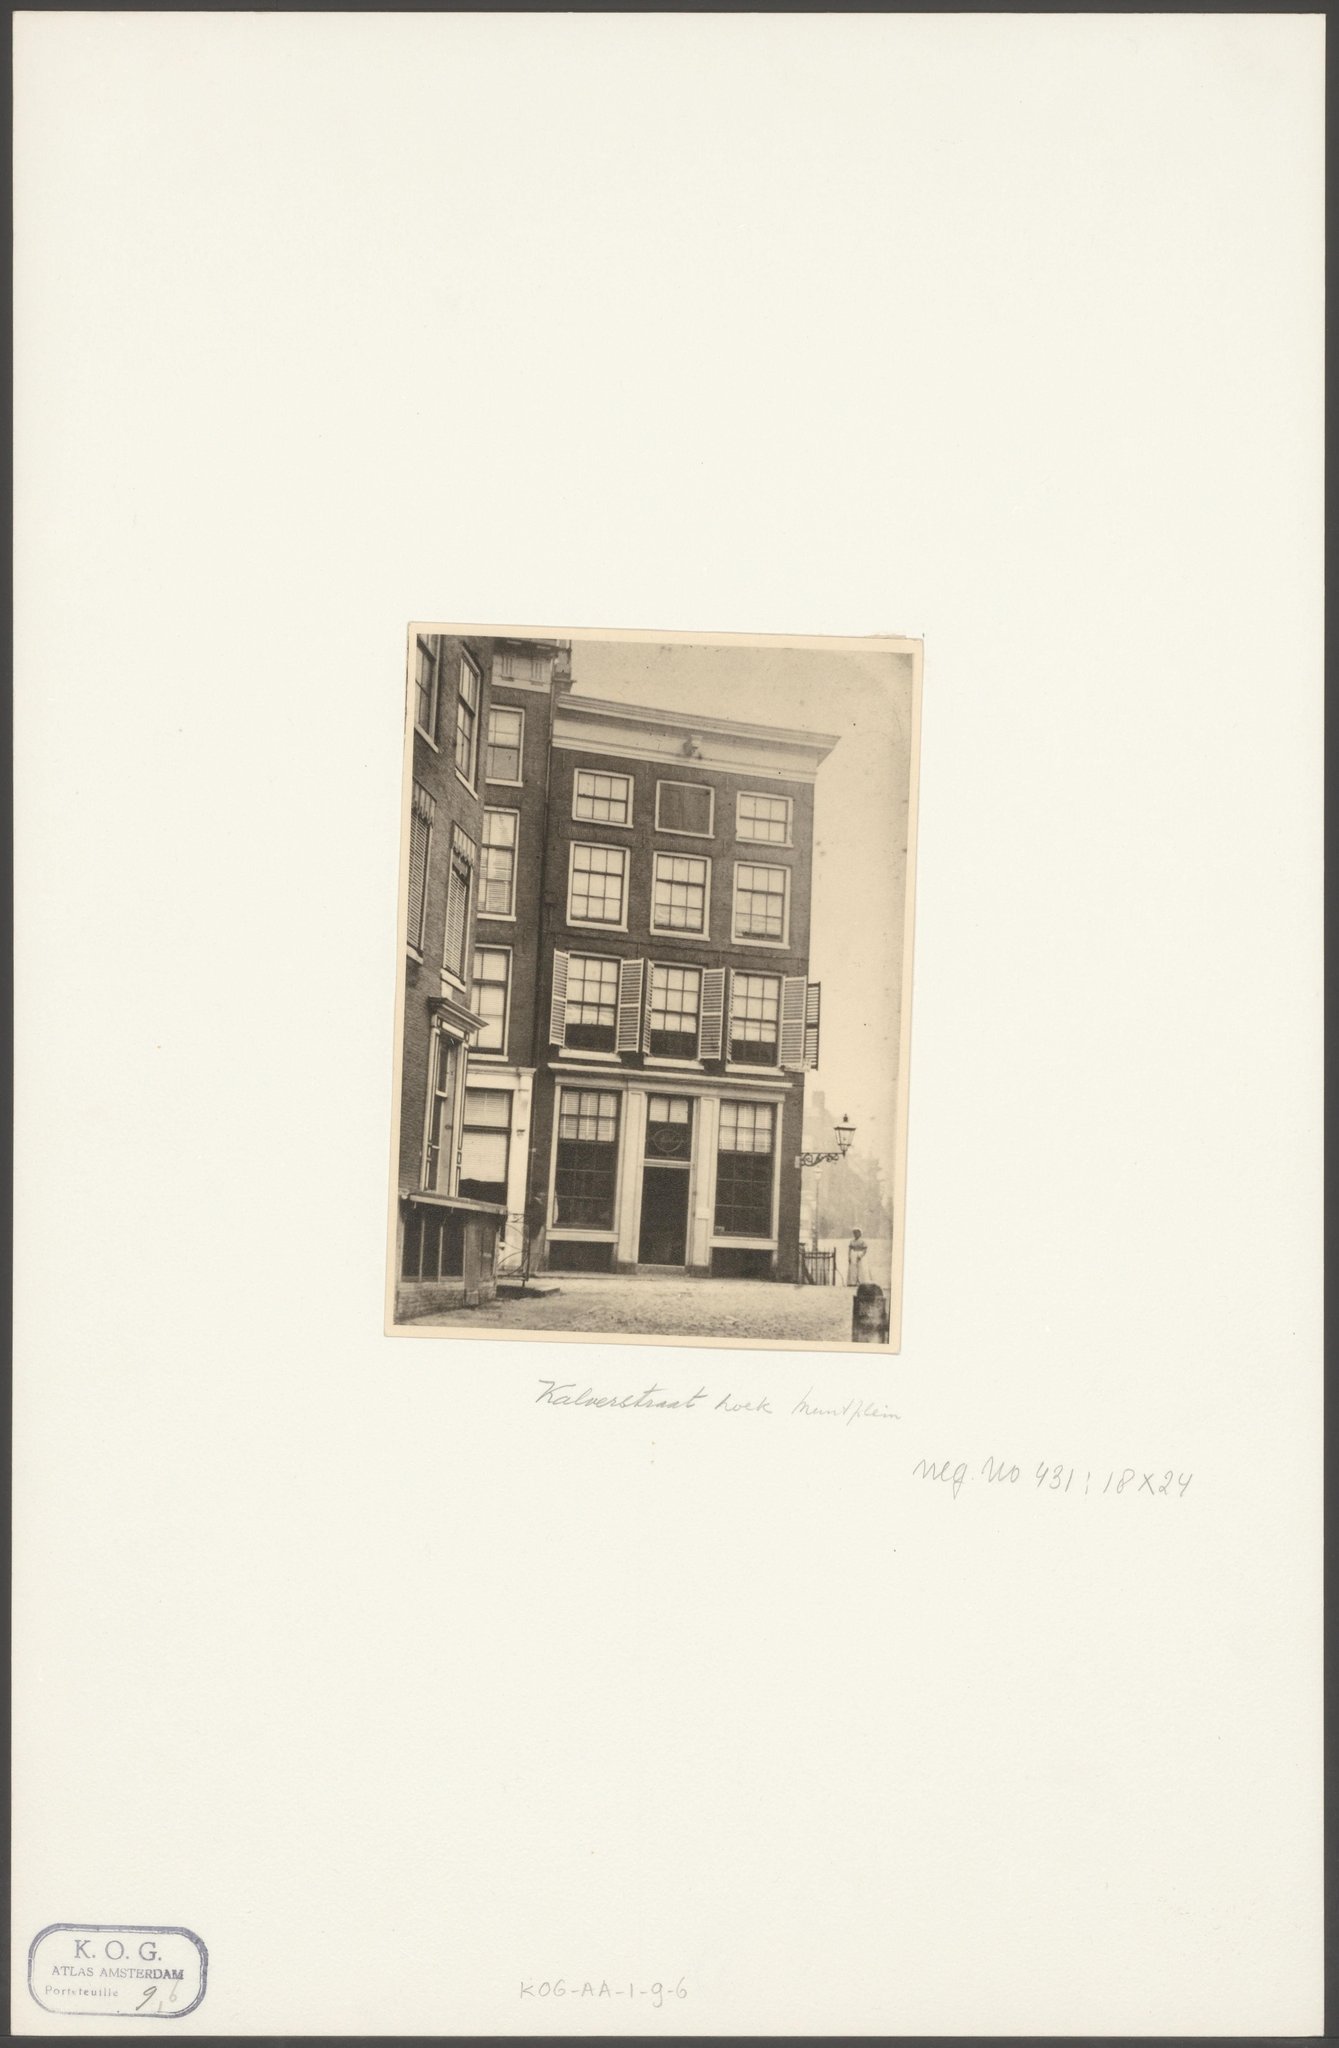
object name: photograph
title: Gezicht op de Kalverstraat, hoek Muntplein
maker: Anonymous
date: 1880-1950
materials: paper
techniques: gelatin silver print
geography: amsterdam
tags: city-view in general; 'veduta', façade (of house or building), street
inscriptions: inscription: ‘Kalverstraat 1’, collector's mark: ‘9,6’ Lugt 1641b, inscription: ‘Kalverstraat hoek Muntplein / neg. no 431: 18x24’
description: Onderwerpsrubriek binnen de Atlas Amsterdam: Kadijksplein, Karthuizerkerkhof, Kattegat, Kattenburg, Kapelsteeg O.Z., Enge Kerksteeg, Kerkstraat, Kinkerstraat, Kolk O.Z., Koningsplein, Kromboomsloot [Krom Boomssloot], Kostverlorenkade, Kwakersdwarspad, Kalverstraat, Keizersgracht (v.d. Brouwersgracht – Amstel), Klerensloot (Gedempte), Klimopstraat, Kloveniersburgwal, Kraansluis.